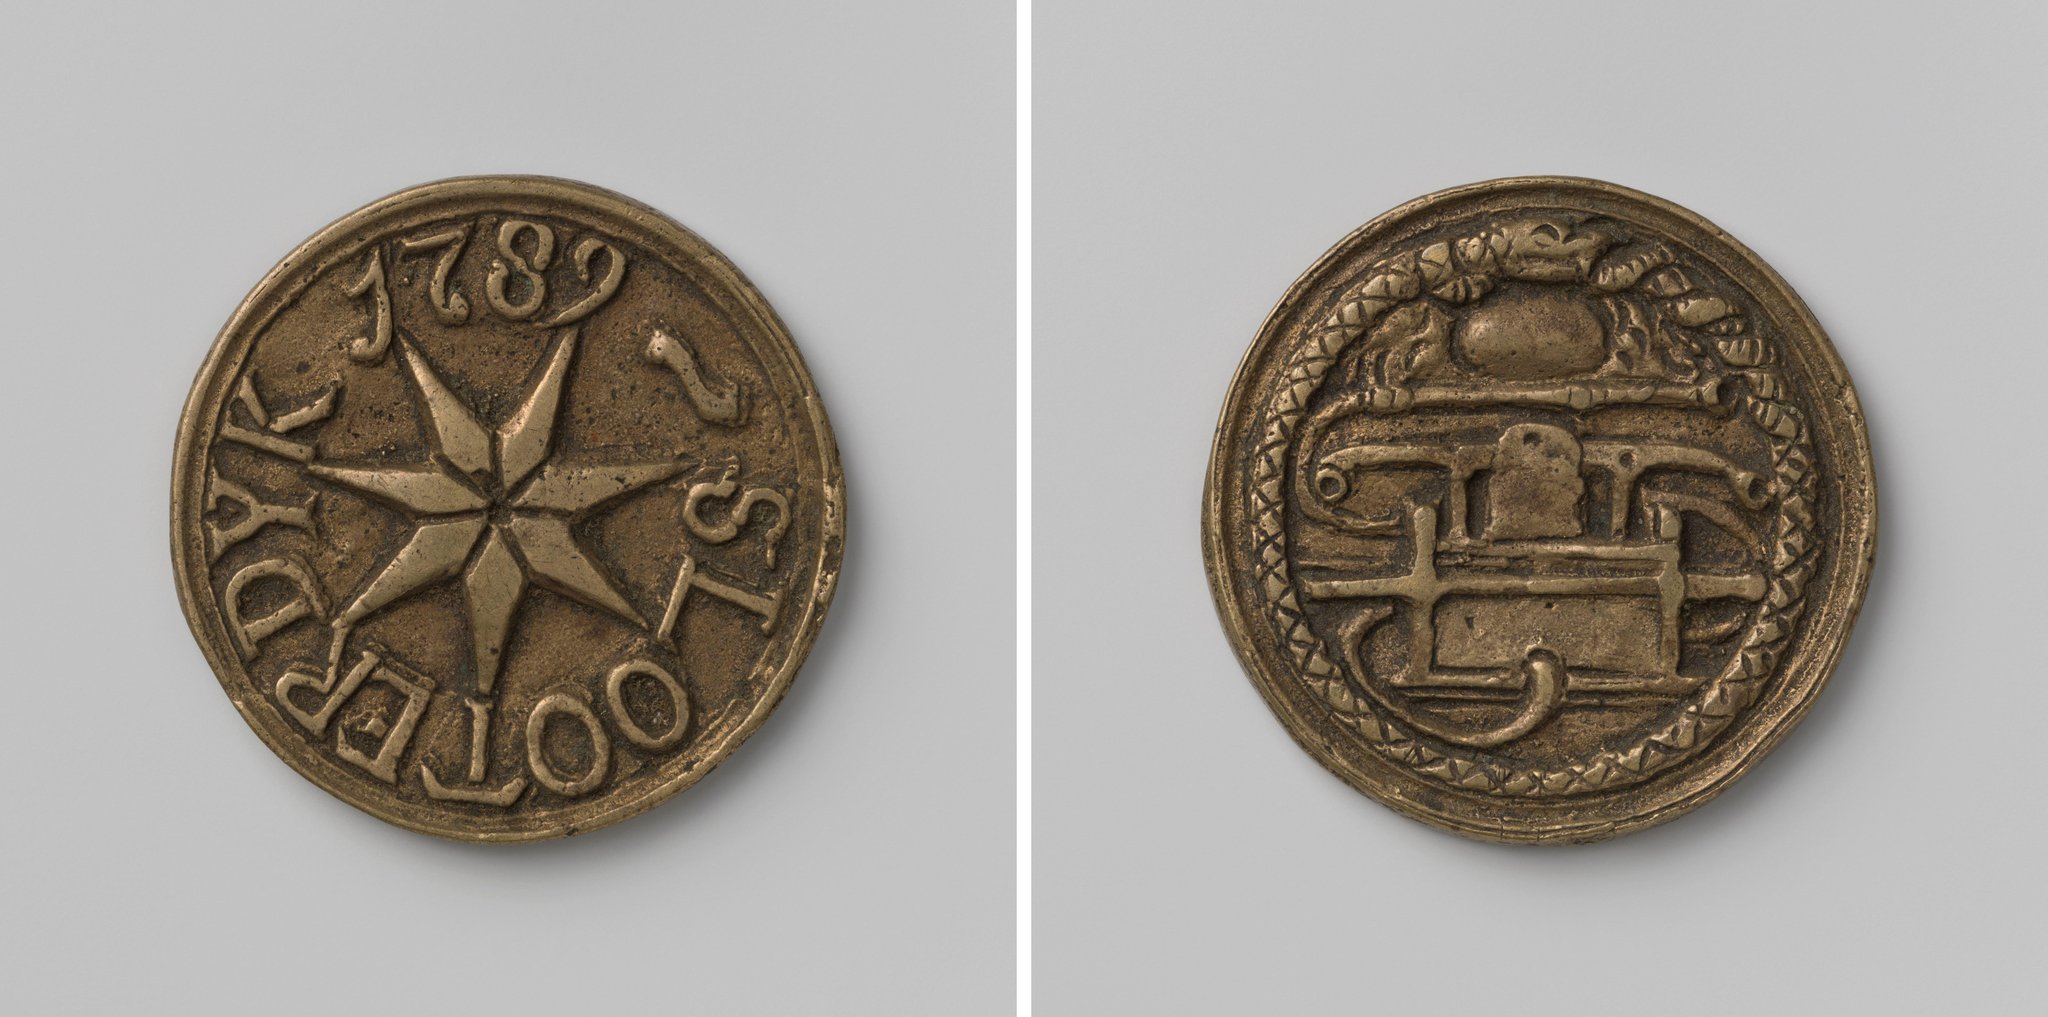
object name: fire engine medal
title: Sloterdijk, brandspuitpenning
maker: Anonymous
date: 1789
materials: brass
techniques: casting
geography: amsterdam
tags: sloterdijk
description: Messing penning. Voorzijde: zevenpuntige ster binnen omschrift. Keerzijde: brandspuit onder leeg cartouche binnen slangerond